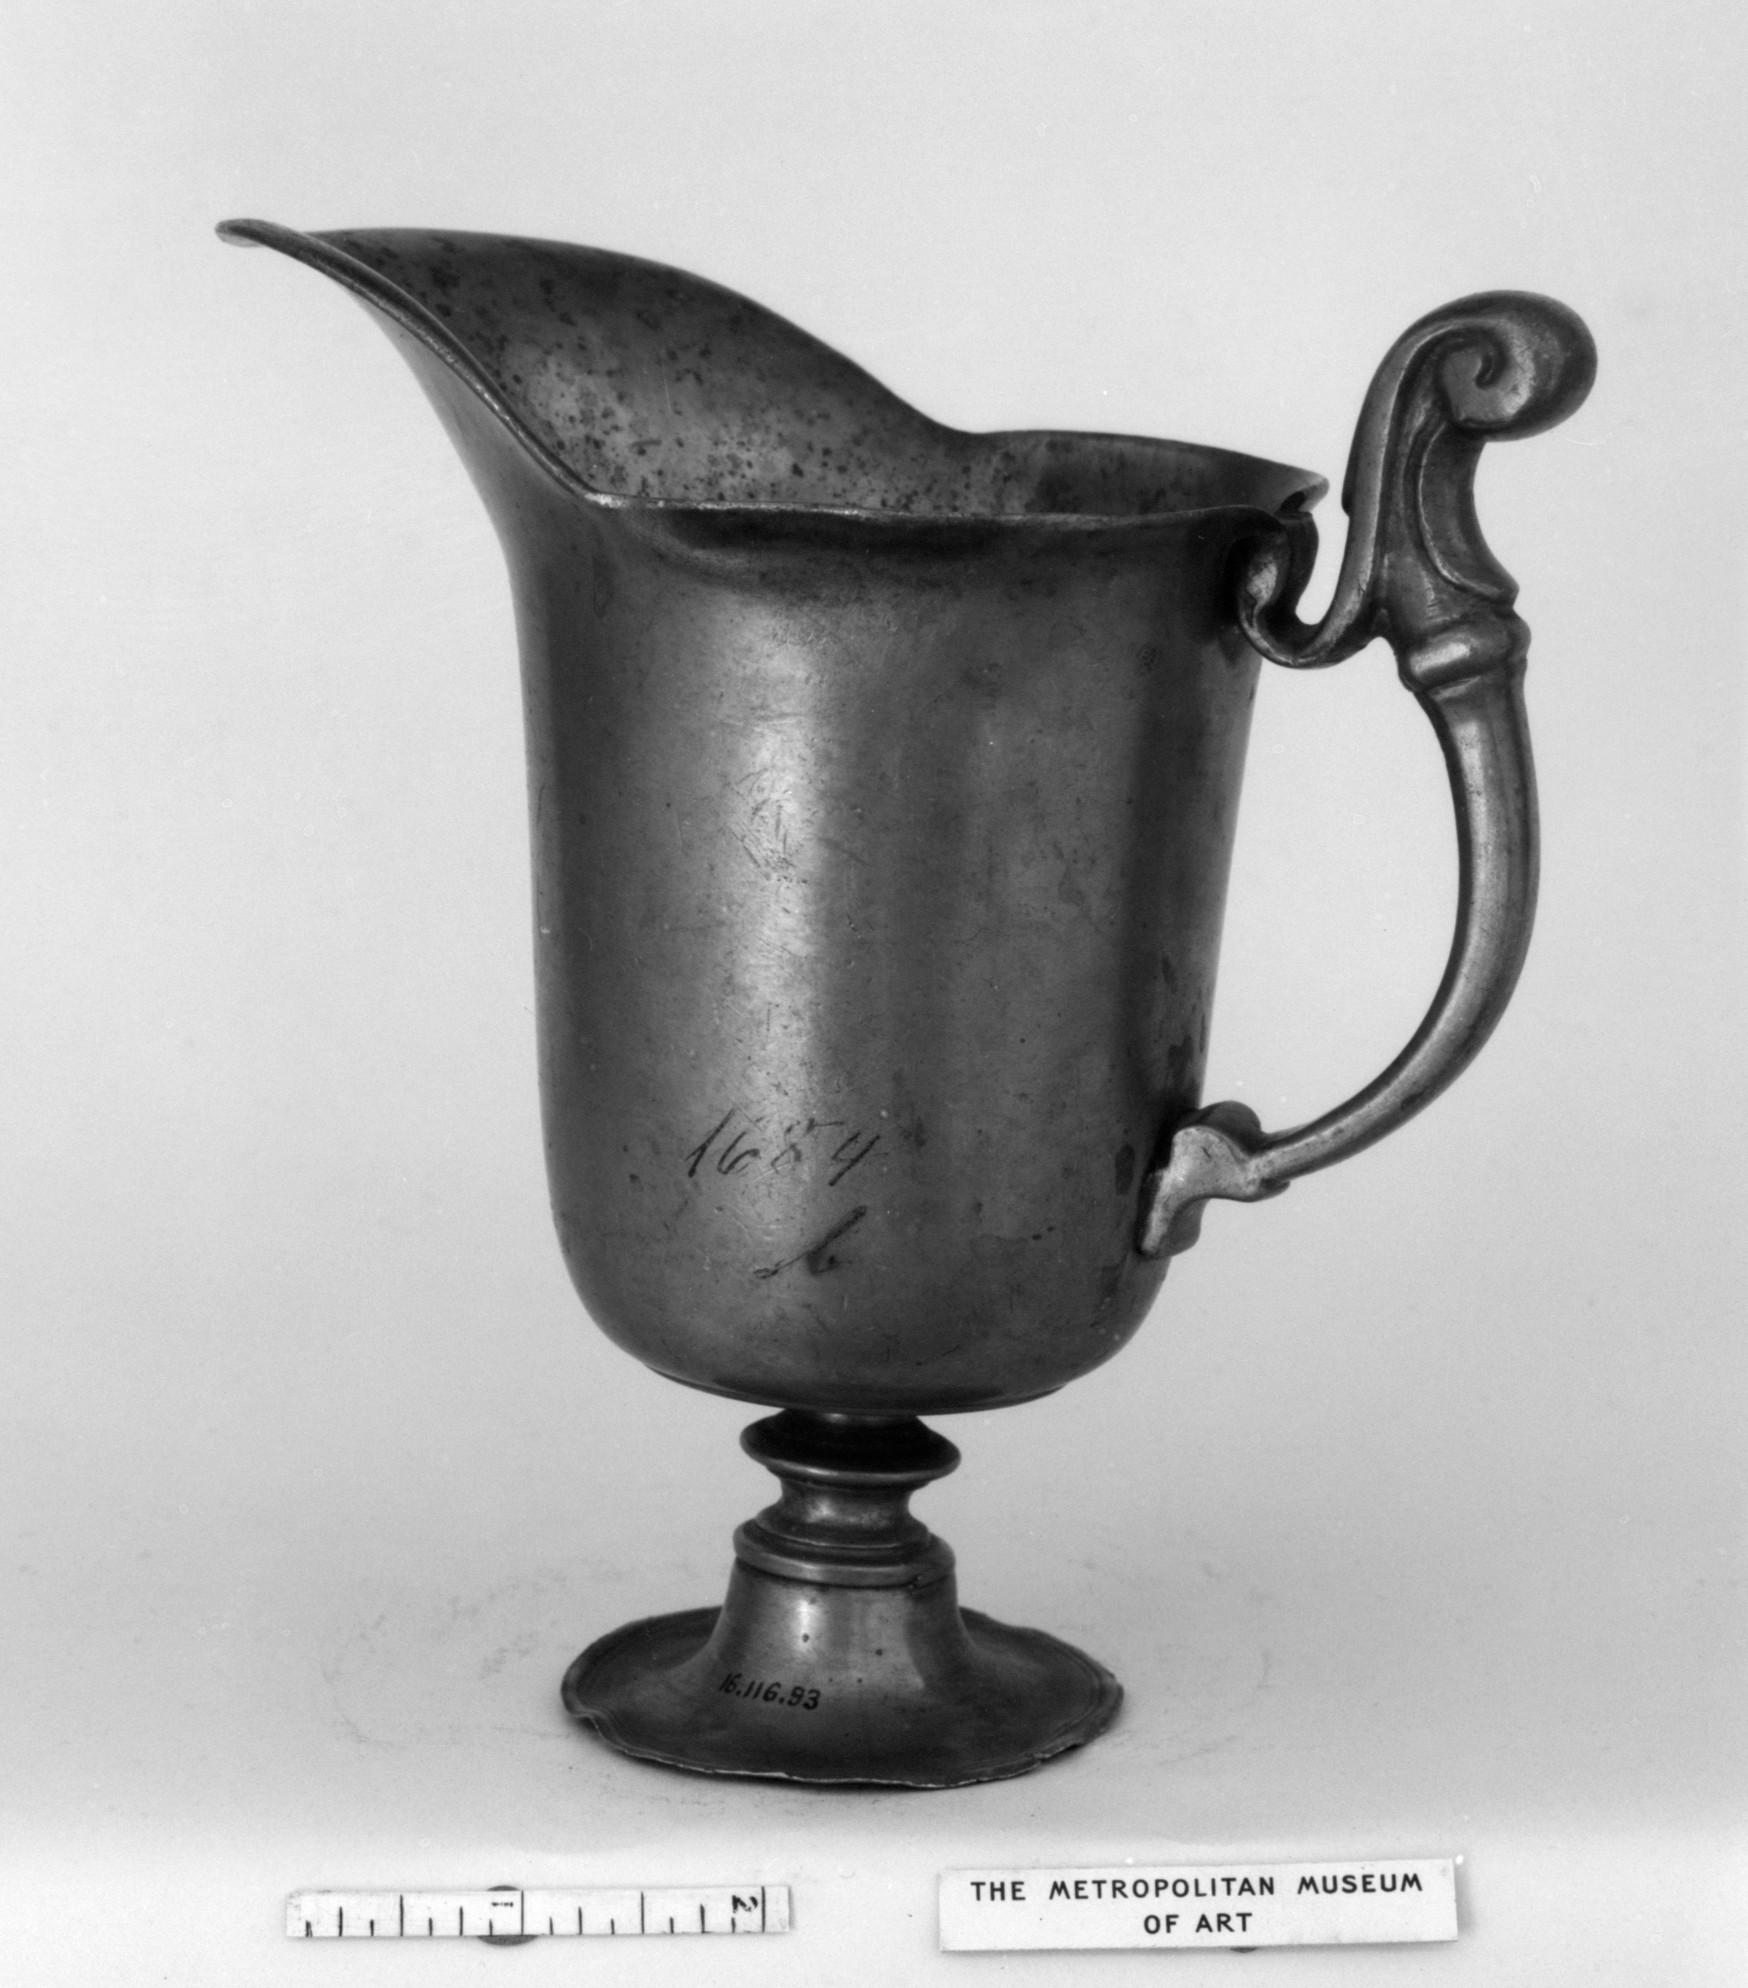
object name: cream jug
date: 1601-1700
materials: pewter